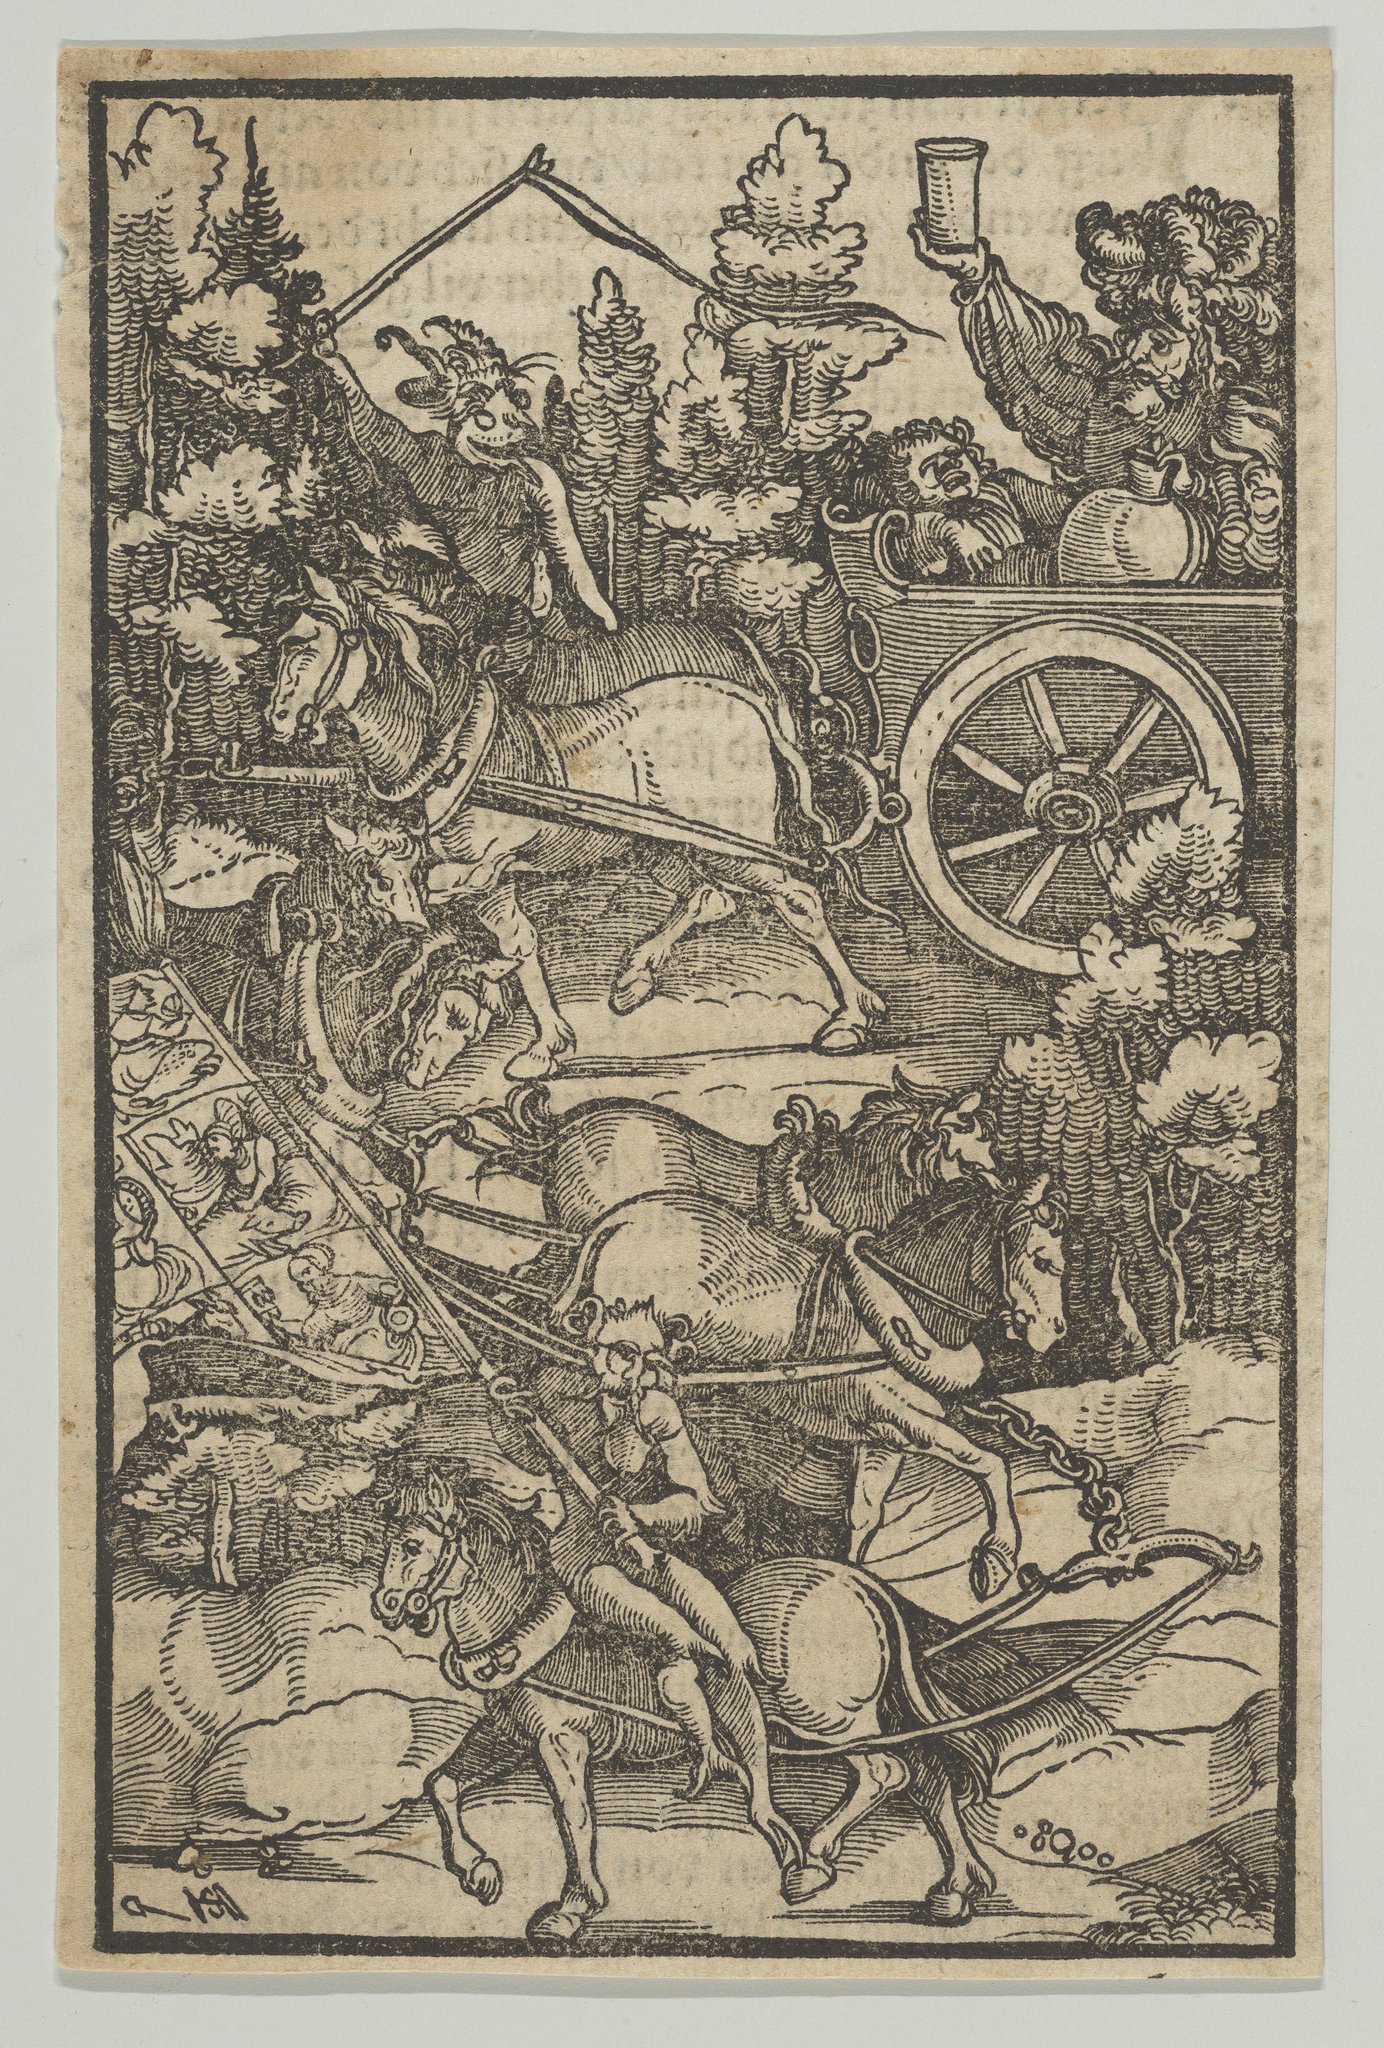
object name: print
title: The Drunken Man on a Chariot on his Way to Hell, from Hymmelwagen auff dem, wer wol lebt...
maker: hans schäufelein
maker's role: artist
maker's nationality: german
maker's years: 1480-1540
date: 1517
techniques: woodcut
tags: drunkenness,men,horses,chariots